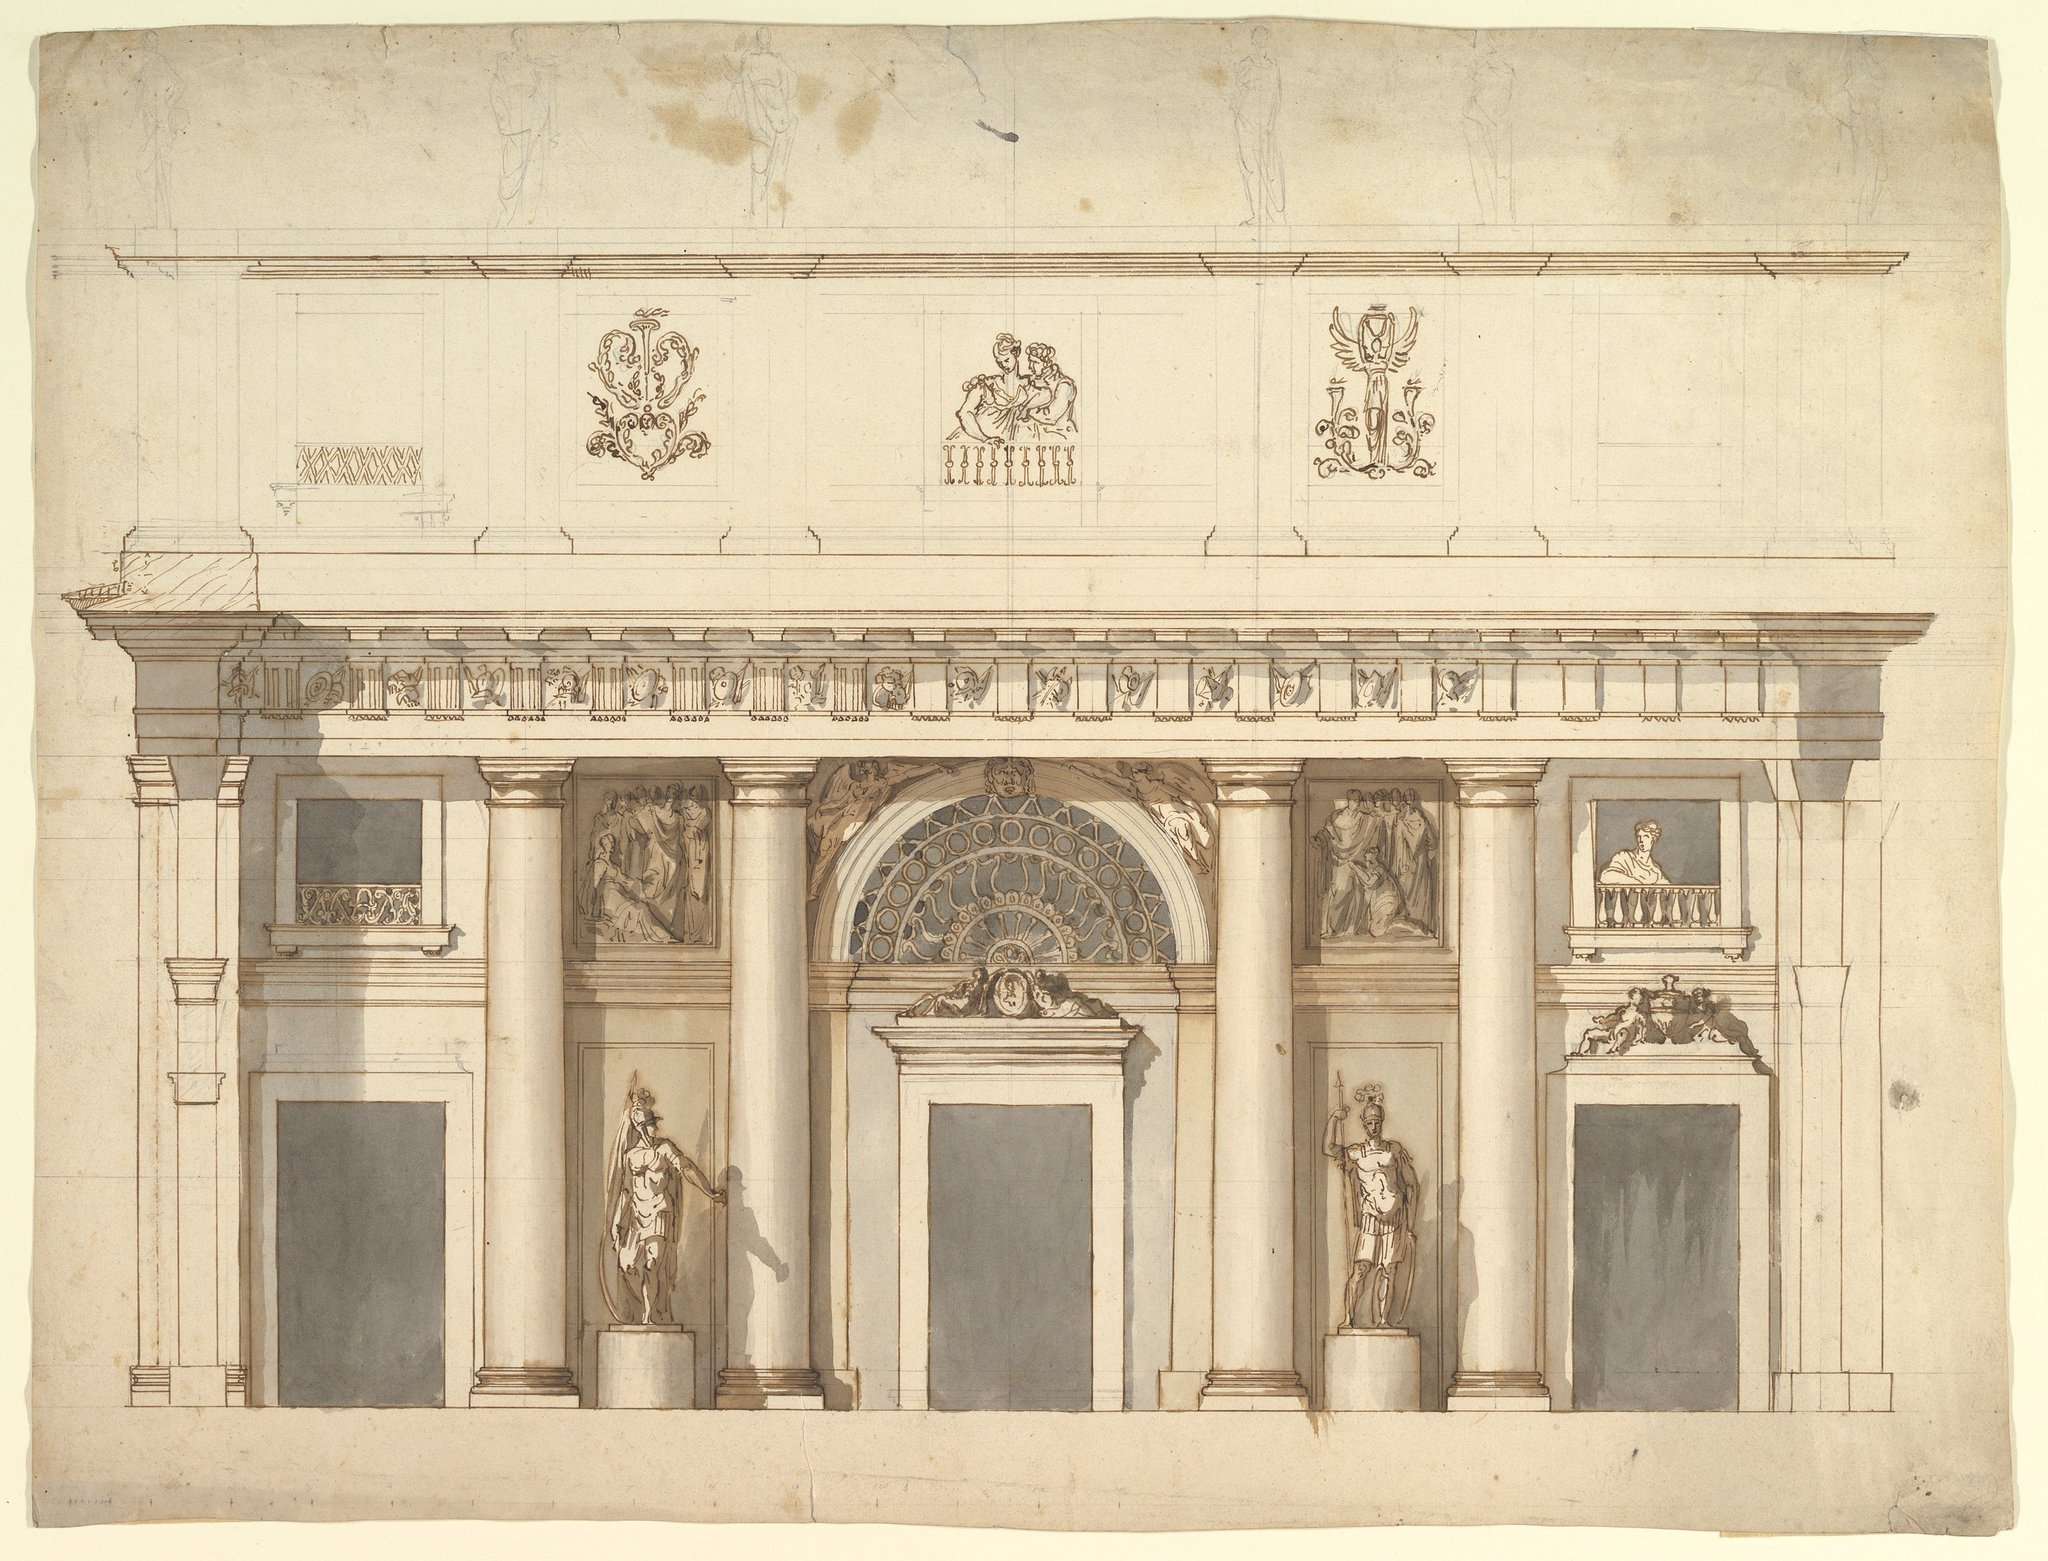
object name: drawing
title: Elevation for a Portico of Doric Order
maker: anonymous, italian, 18th or early 19th century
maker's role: artist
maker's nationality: italian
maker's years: 1700-1850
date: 1767-1833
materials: graphite, ink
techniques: brush, pen, wash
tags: architecture,columns